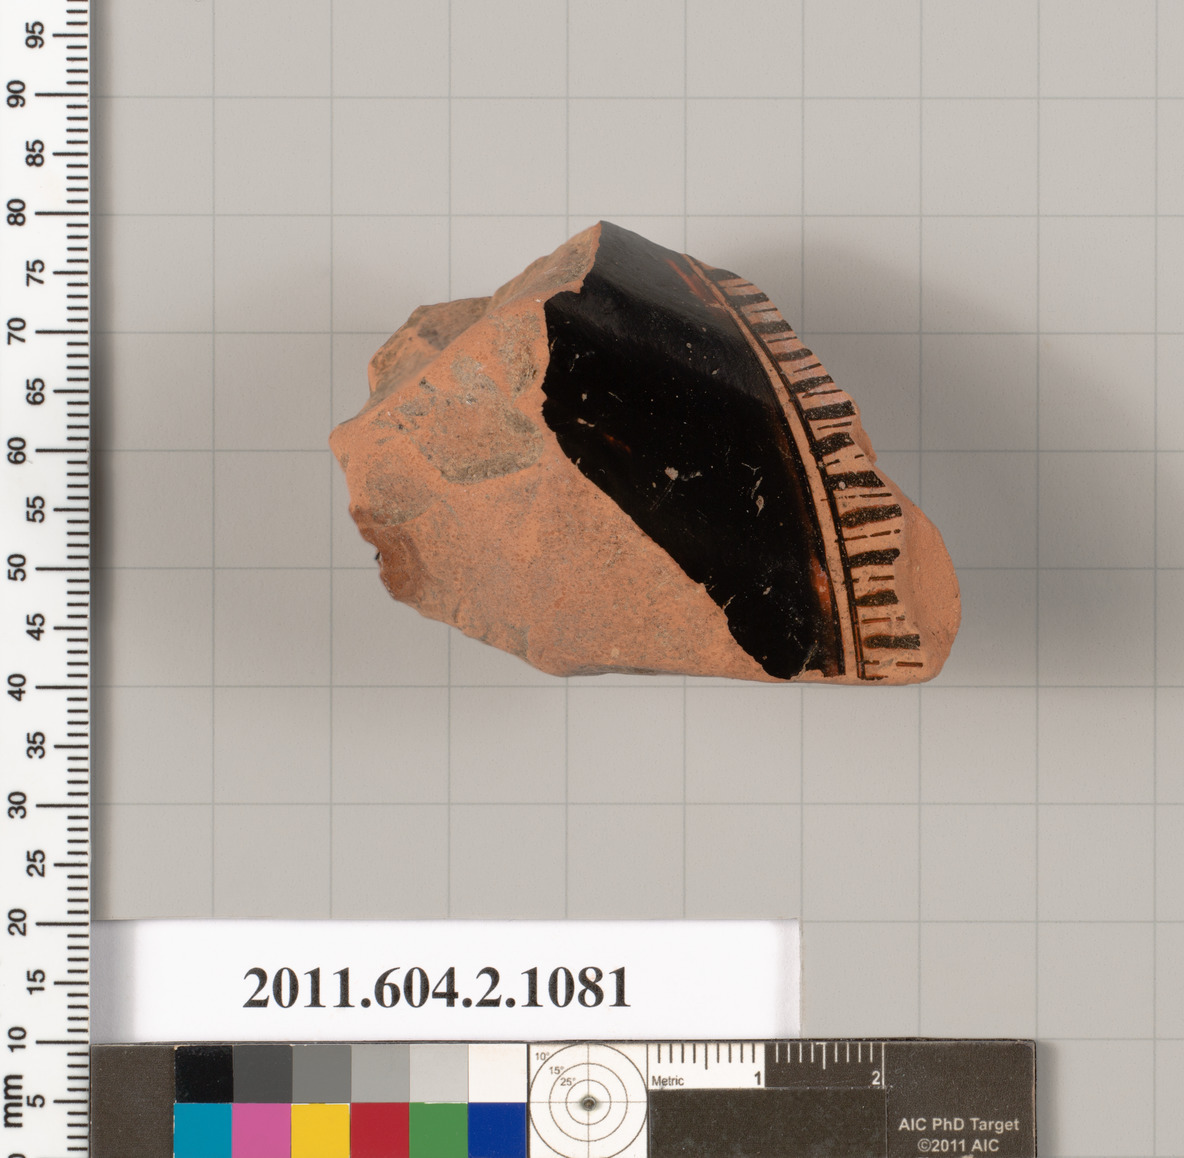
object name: hydria fragment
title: Terracotta fragment of a hydria (water jar)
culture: greek, attic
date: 500-476 BCE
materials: terracotta